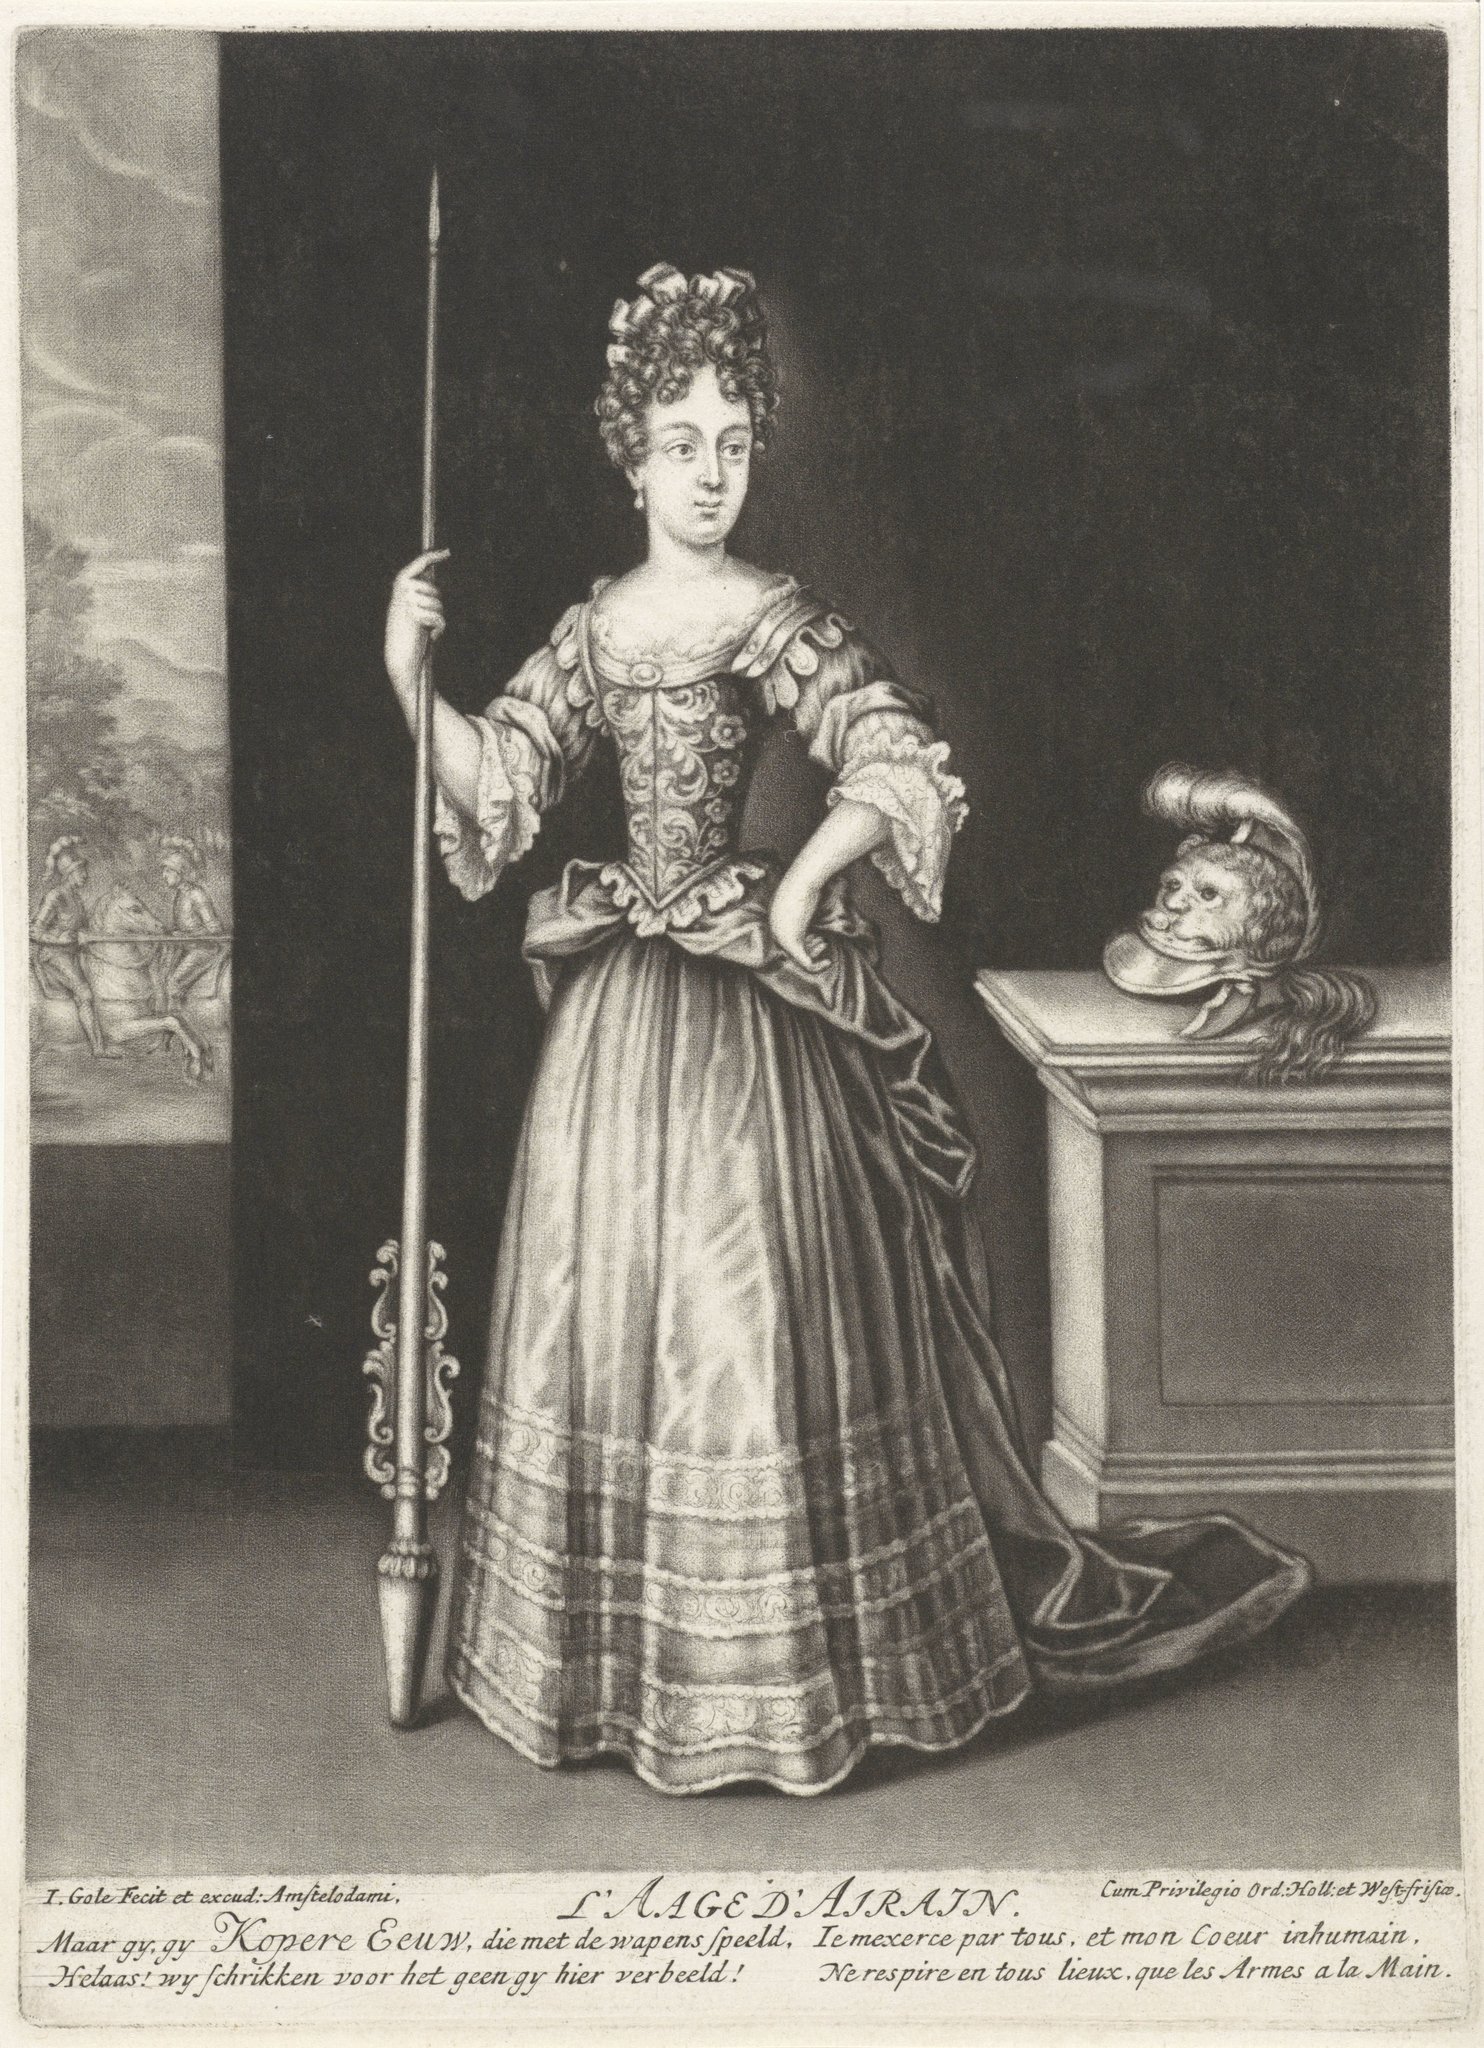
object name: print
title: Bronzen eeuw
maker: jacob gole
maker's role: print maker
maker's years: 1660-1724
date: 1670-1724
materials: paper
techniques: engraving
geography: amsterdam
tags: helved weapons, polearms (for striking, hacking, thrusting): lance, personification of the bronze age; 'età del bronzo', 'età del rame' (ripa)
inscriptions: collector's mark: Lugt 2228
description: Het Bronzen tijdperk: vrouw met een lans en een helm. Op de achtergrond twee soldaten te paard. De prent refereert aan het mythologisch geïnspireerde idee dat tijdens de Bronzen eeuw de mens steeds meer moest werken om zich in leven te houden. Bovendien stond eigendom centraal in het leven. De prent maakt deel uit van een serie over de vier tijdperken.